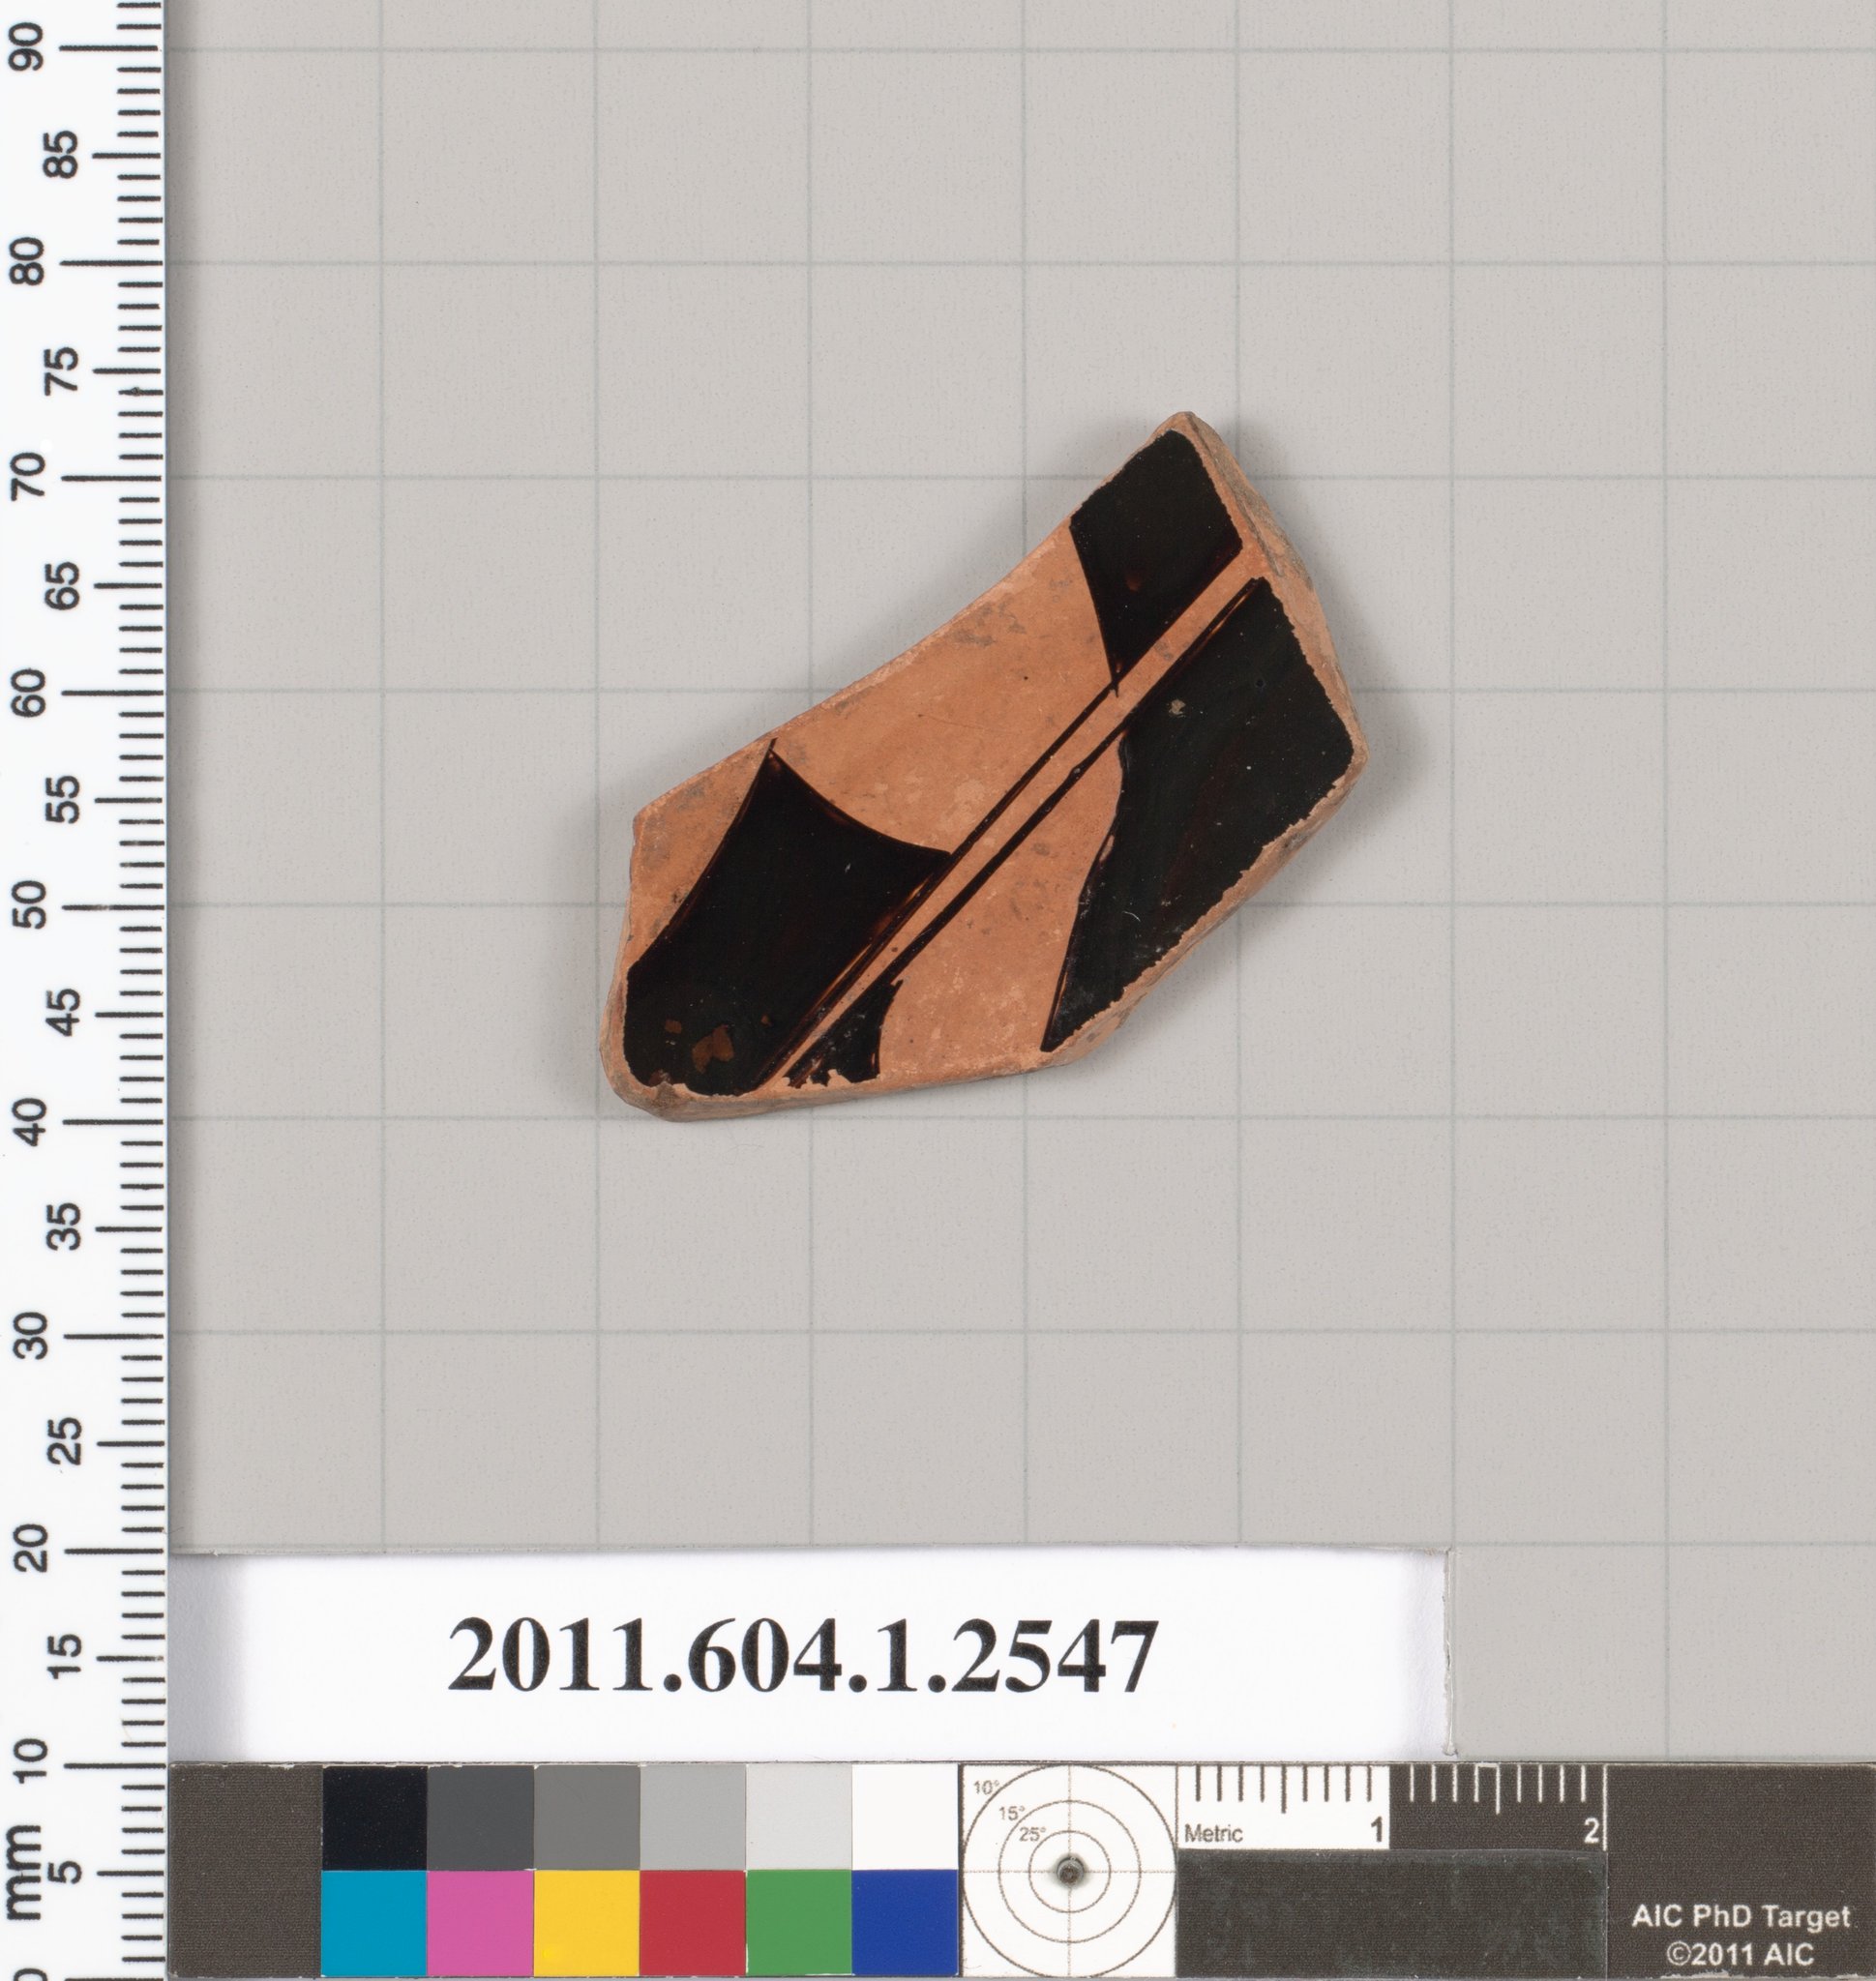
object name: kylix fragment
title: Terracotta fragment of a kylix (drinking cup)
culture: greek, attic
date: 490-480 BCE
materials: terracotta